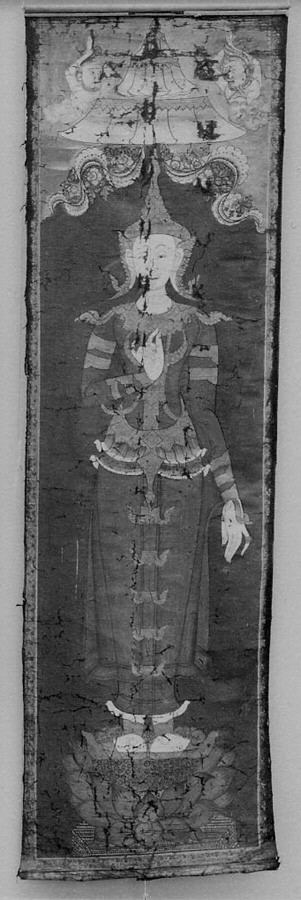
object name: hanging scroll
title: Standing Buddha(?)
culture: thai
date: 1601-1800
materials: textile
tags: buddhism,buddha